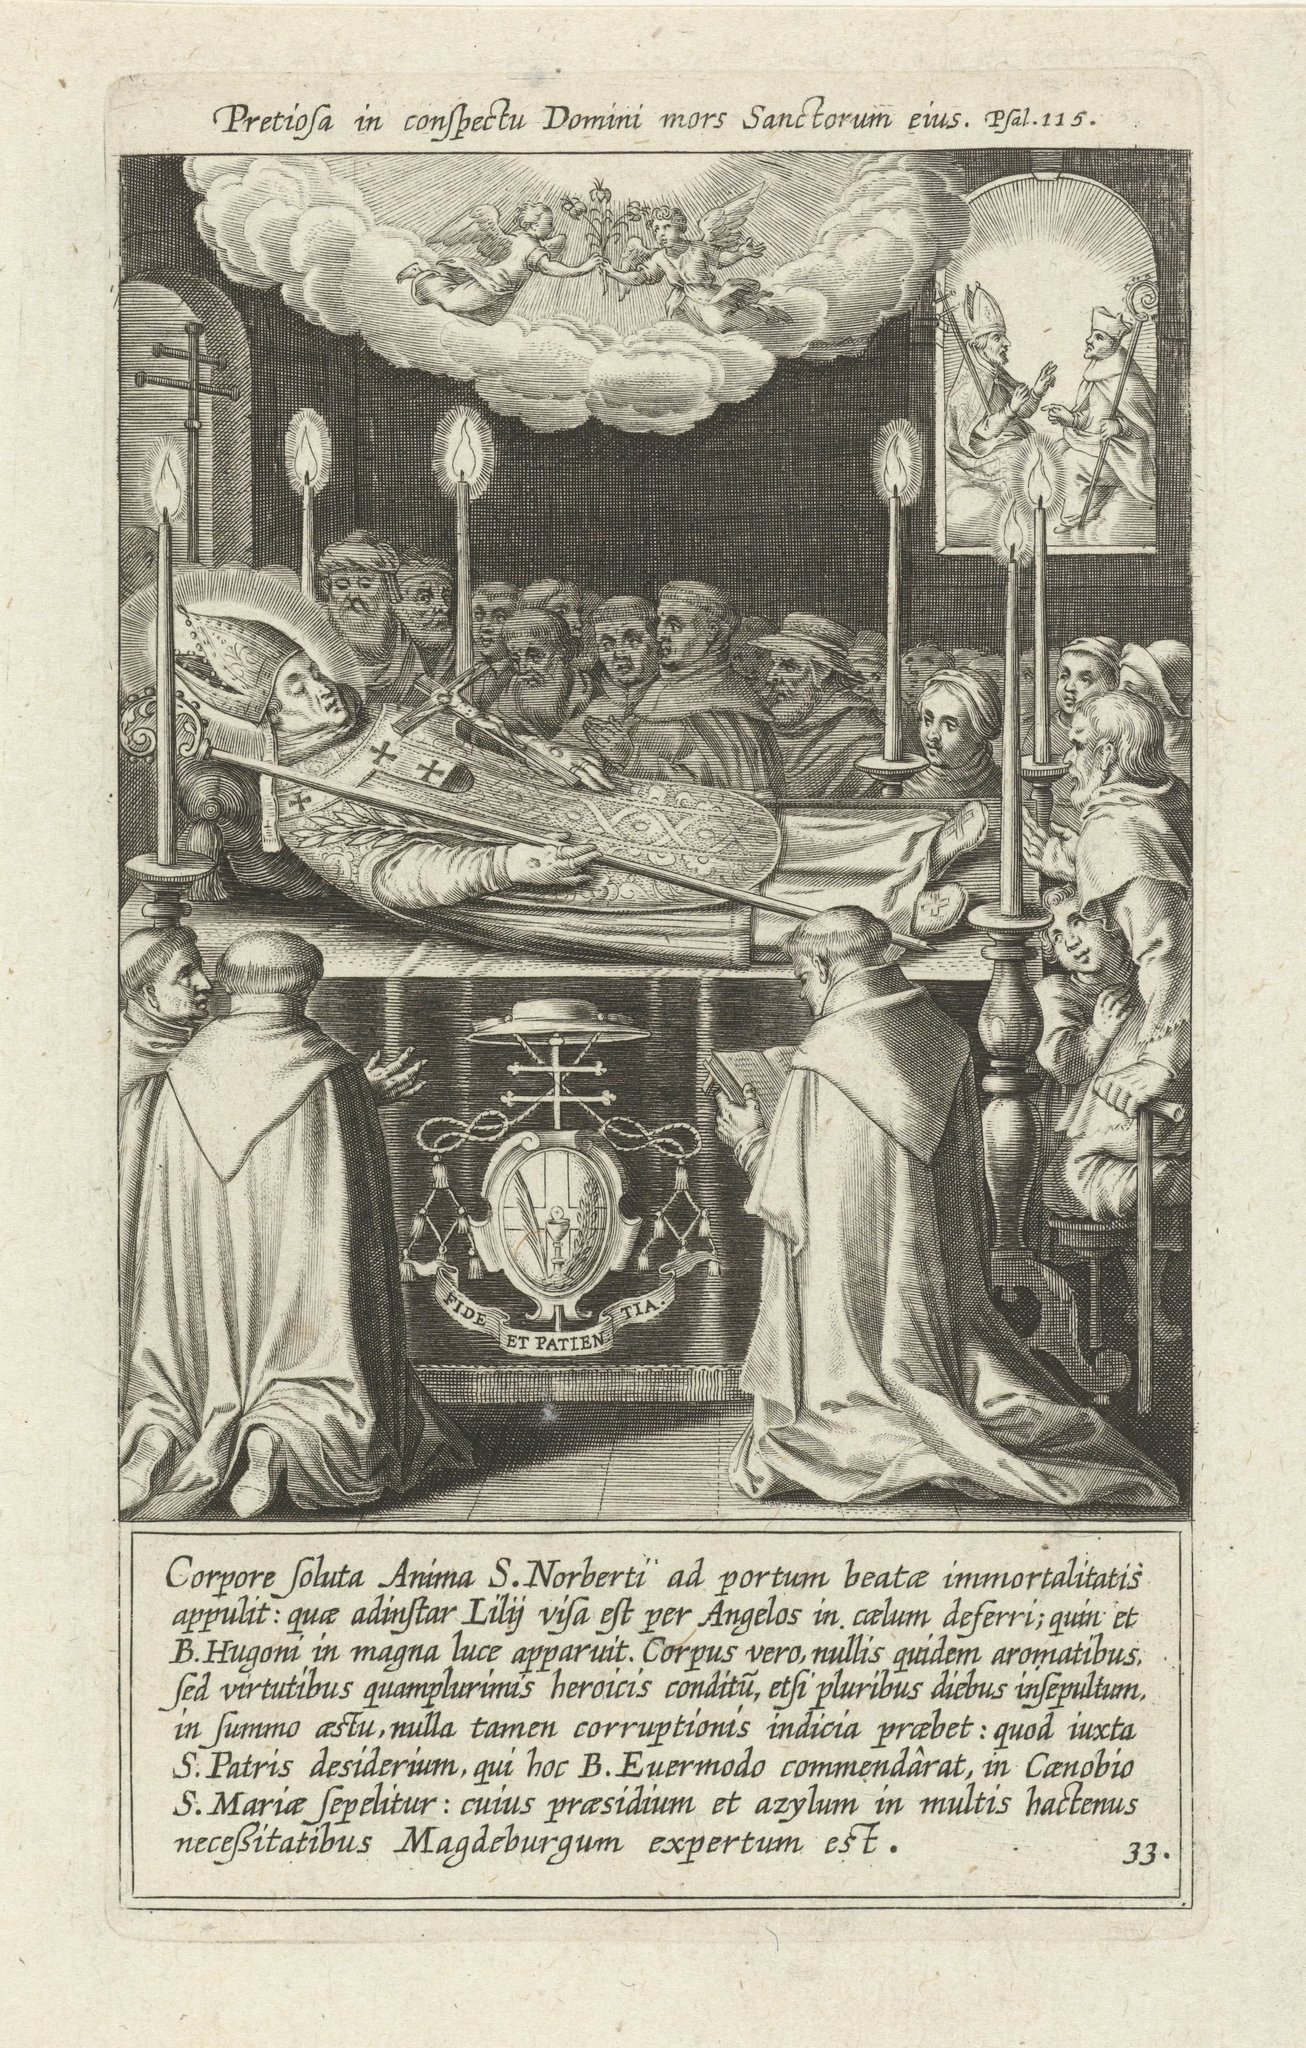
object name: book illustration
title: De heilige Norbertus, opgebaard in Maagdenburg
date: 1622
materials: paper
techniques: engraving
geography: antwerp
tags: deathbed of st. norbert (+ angel(s))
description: De heilige Norbertus ligt in zijn ambtsgewaad van aartsbisschop opgebaard in Maagdenburg. Rondom hem biddende monniken. Boven in de lucht vliegen twee engelen. De prent heeft twee Latijnse opschriften: een boven en een onder de voorstelling.